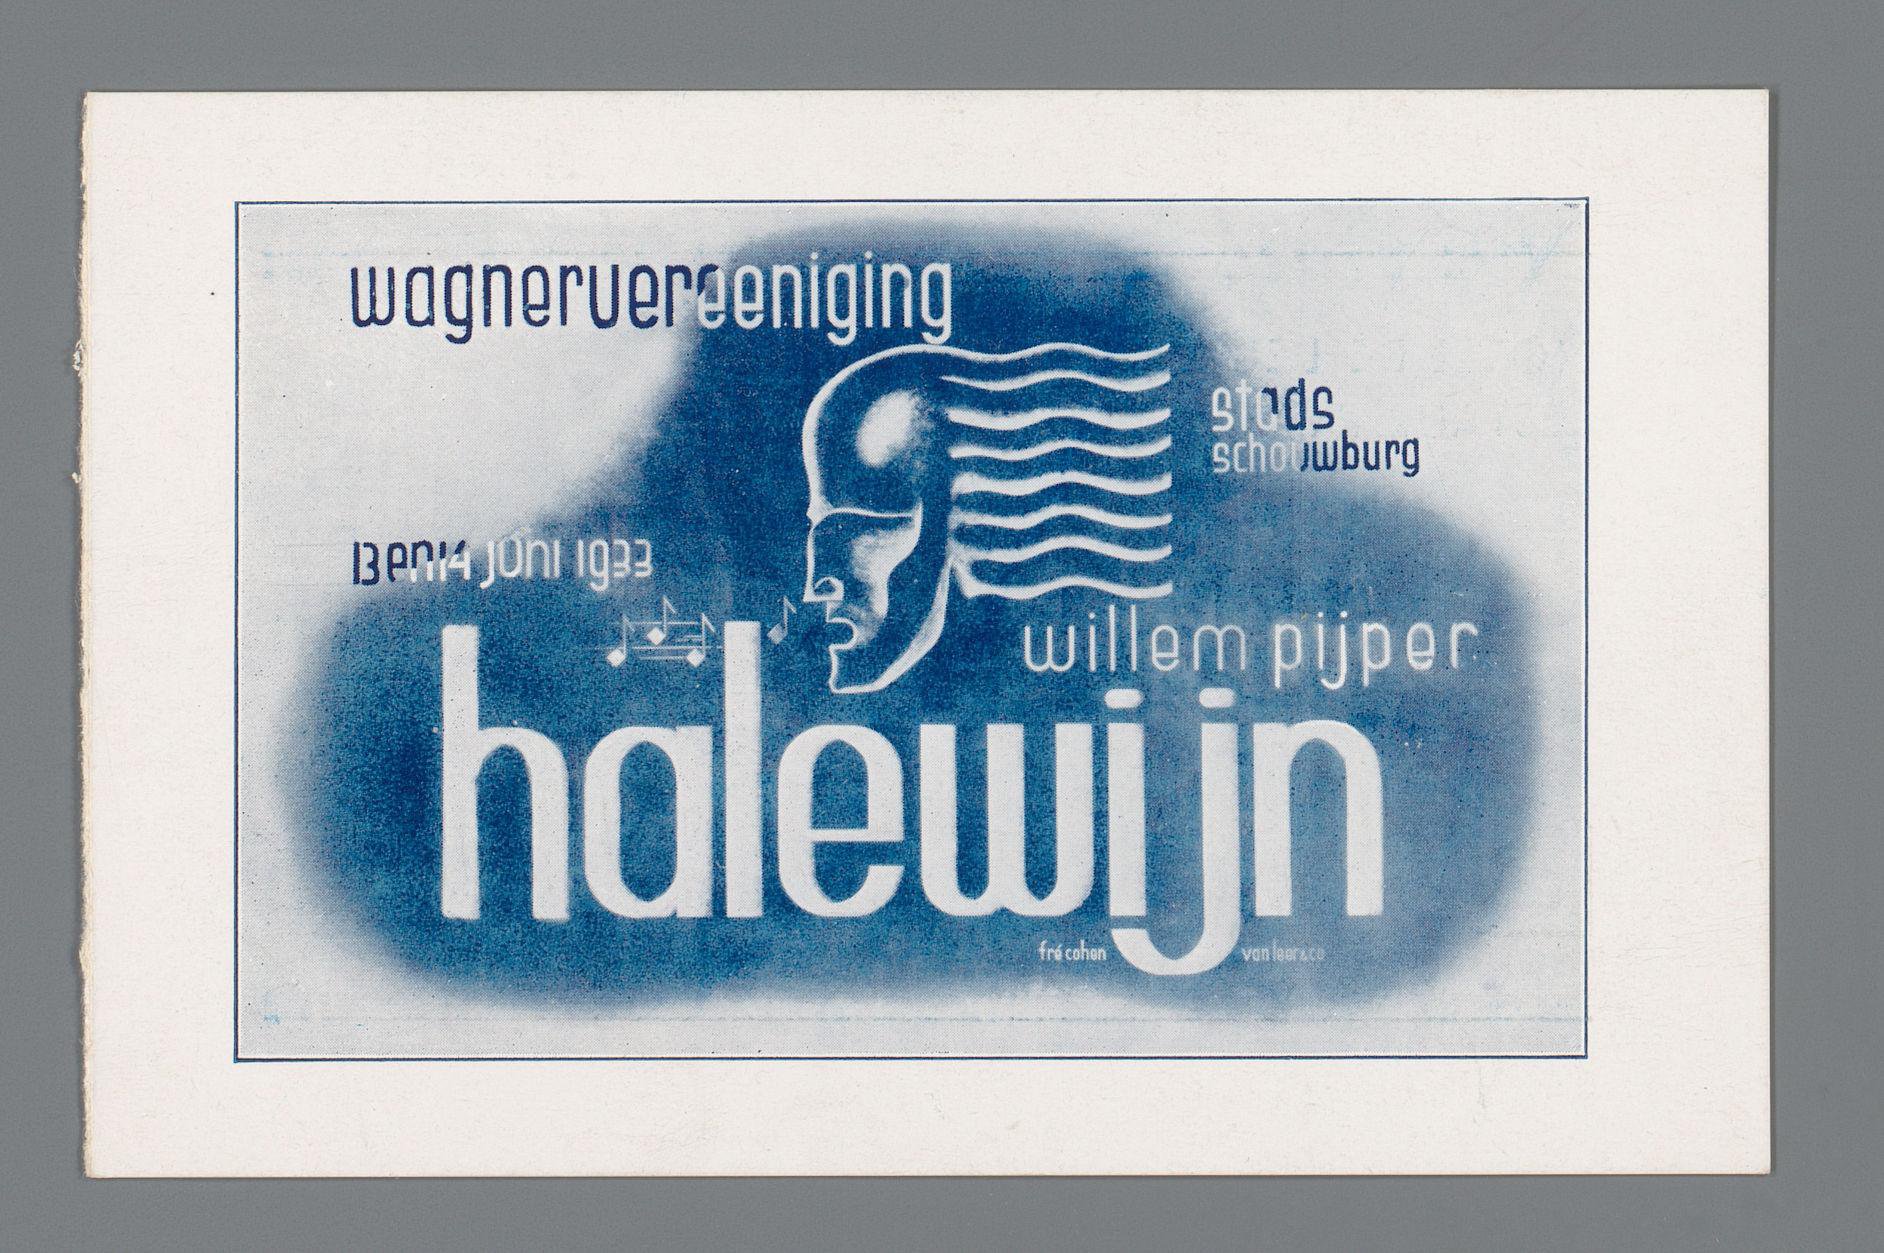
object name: reclamebiljet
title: wagnervereeniging willem pijper halewijn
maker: fré cohen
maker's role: draughtsman, print maker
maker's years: 1903-1943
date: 1906-1933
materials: paper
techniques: autotype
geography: netherlands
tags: zeist, advertising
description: Reclamebiljet van restaurant Excelsior van Hotel de l'Europe voor een souper na afloop van de uitvoering van de opera Halewijn van Pijper door de Wagnervereeniging, juni 1933. Illustratie in blauw op voorzijde, tekst op achterzijde. Verkleinde reproductie naar de affiche.